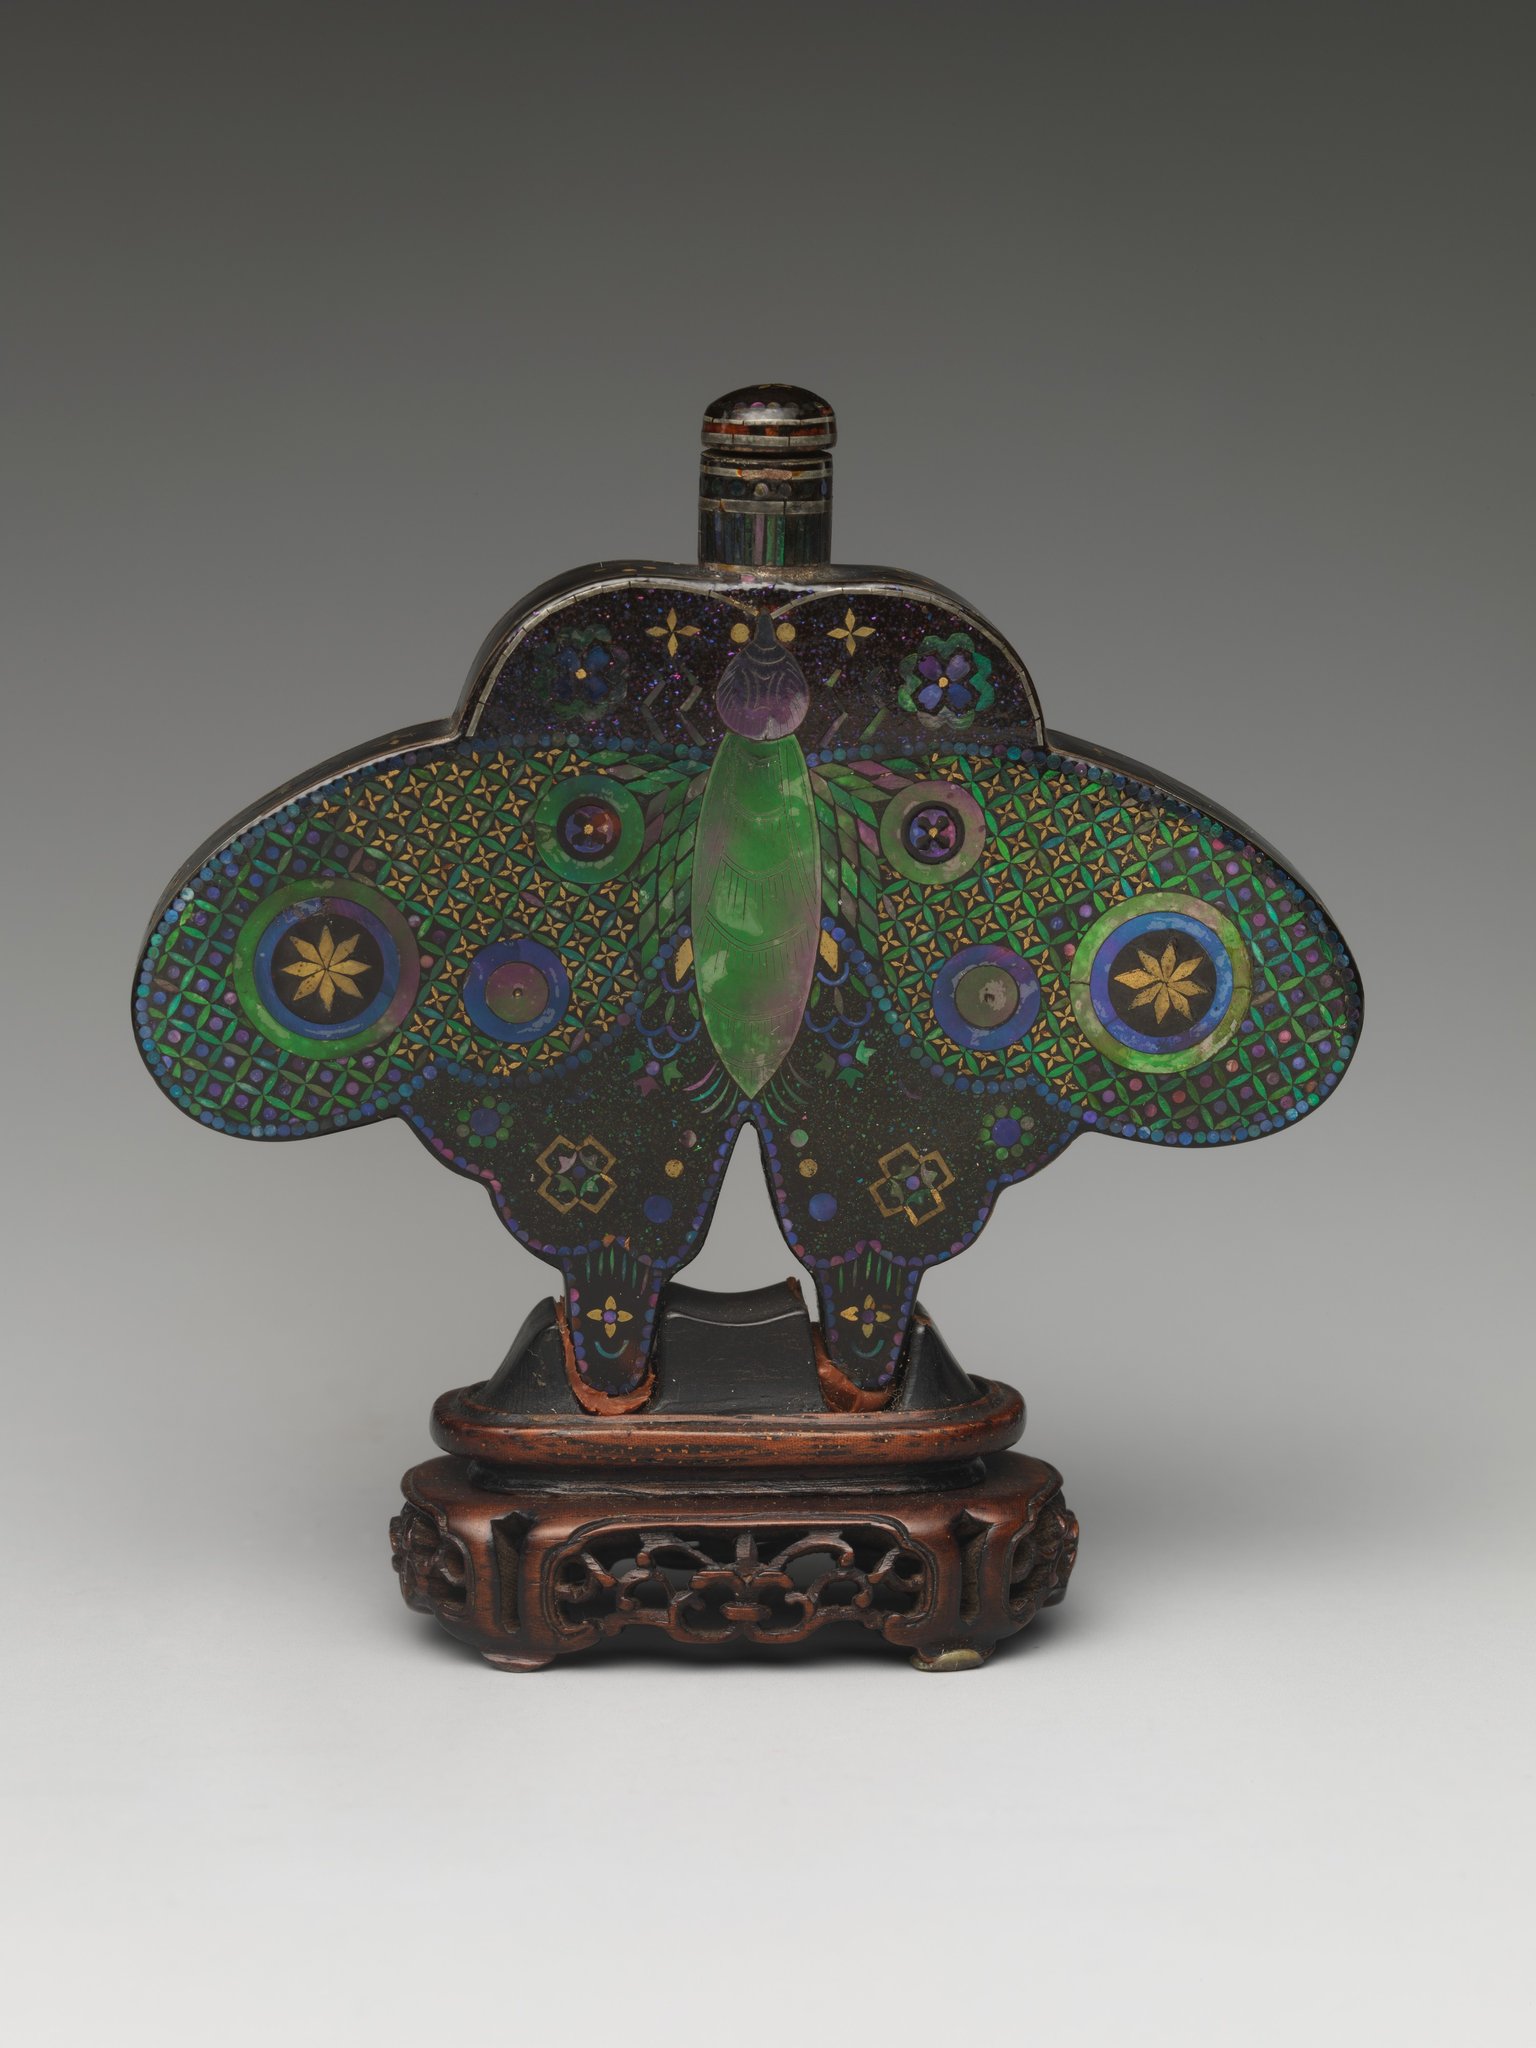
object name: snuff bottle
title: Snuff bottle in the shape of a butterfly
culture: chinese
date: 1801-1900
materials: gold, lacquer, metal, mother of pearl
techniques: inlay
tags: butterflies